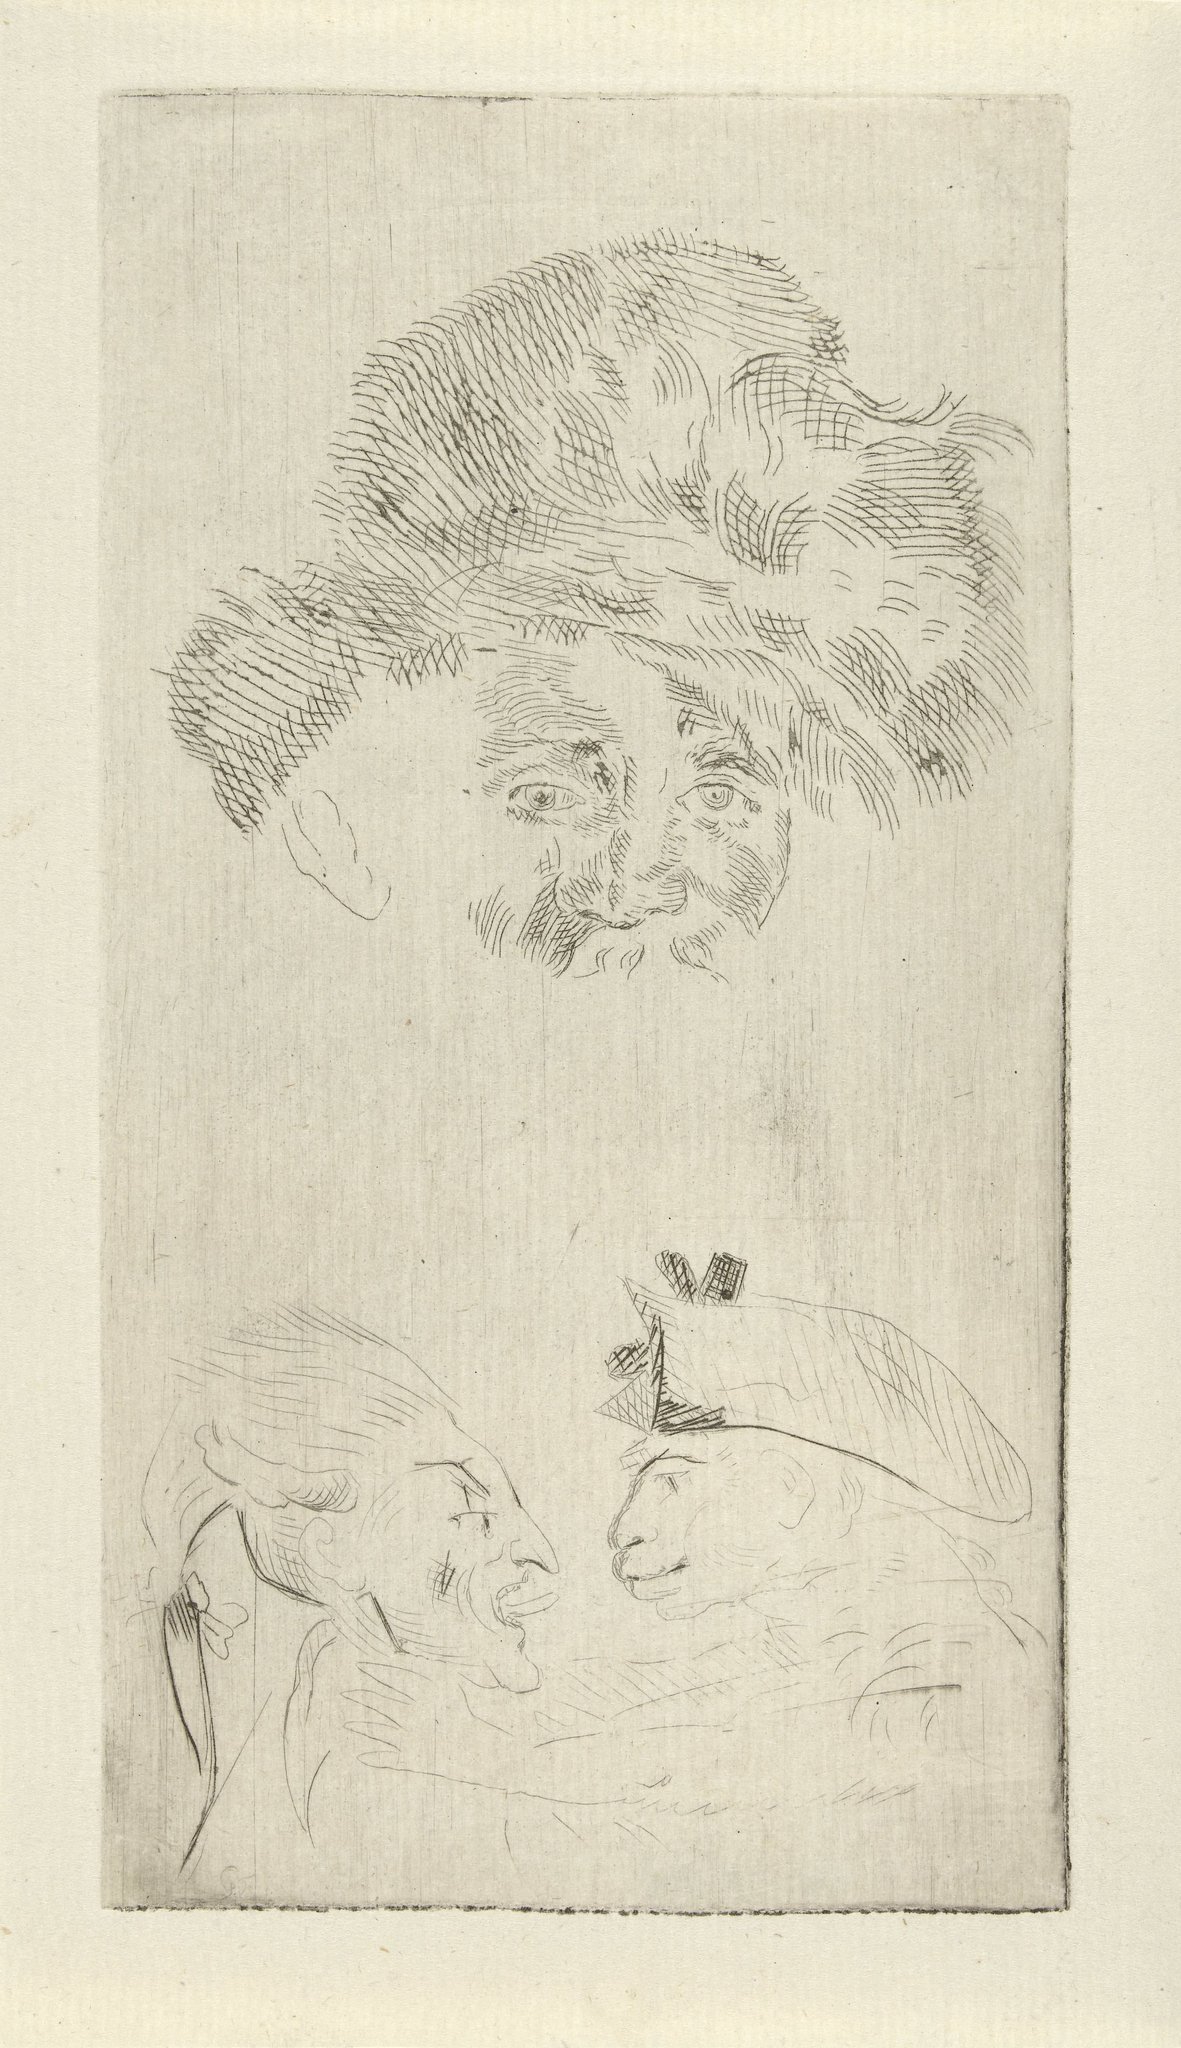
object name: print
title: Studieblad met drie koppen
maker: jac. franc. gaal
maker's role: print maker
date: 1750-1799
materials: paper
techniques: etching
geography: netherlands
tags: historical persons not known by name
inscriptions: collector's mark: Lugt 240